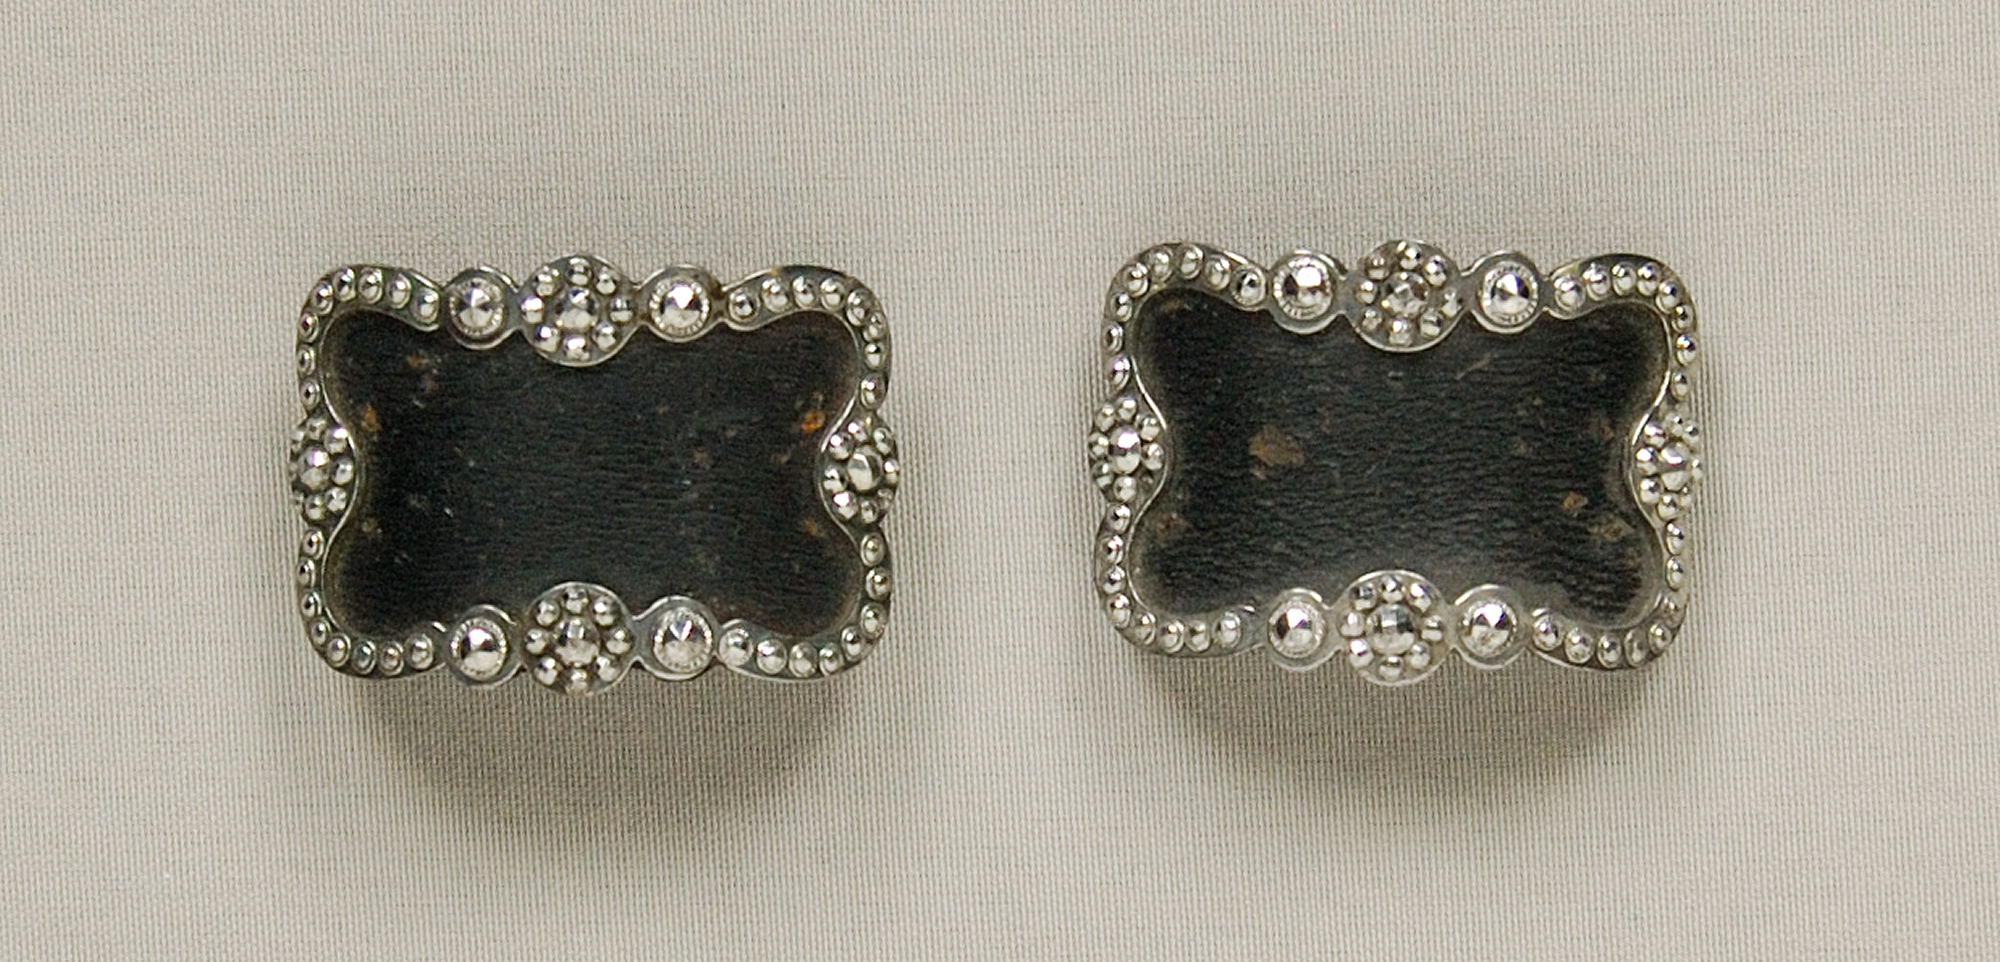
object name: shoe buckle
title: Shoe buckles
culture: american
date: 1876-1900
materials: leather, metal